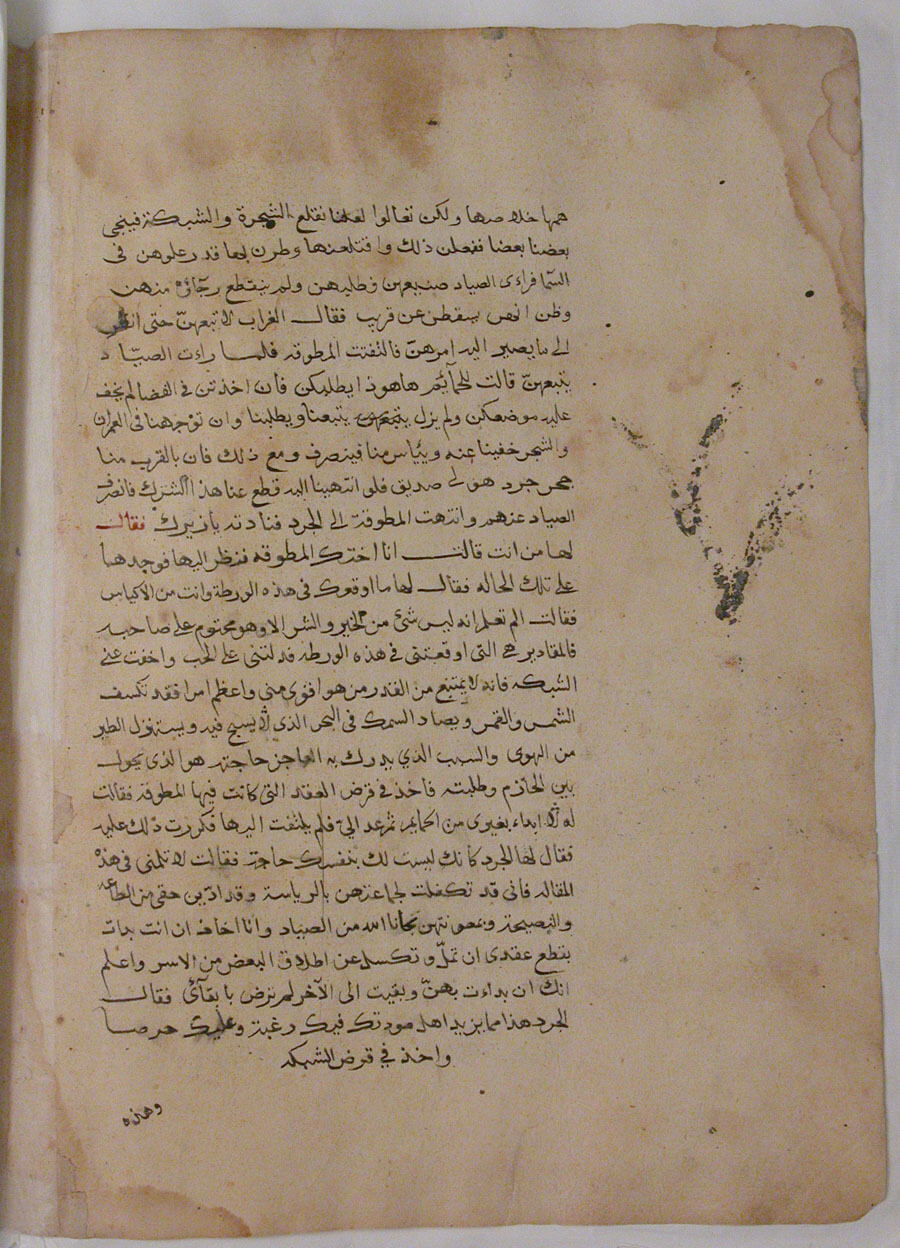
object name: folio from an illustrated manuscript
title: Page of Calligraphy from a Kalila wa Dimna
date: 1526-1550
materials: ink, paper, watercolor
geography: india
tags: arabic,calligraphy